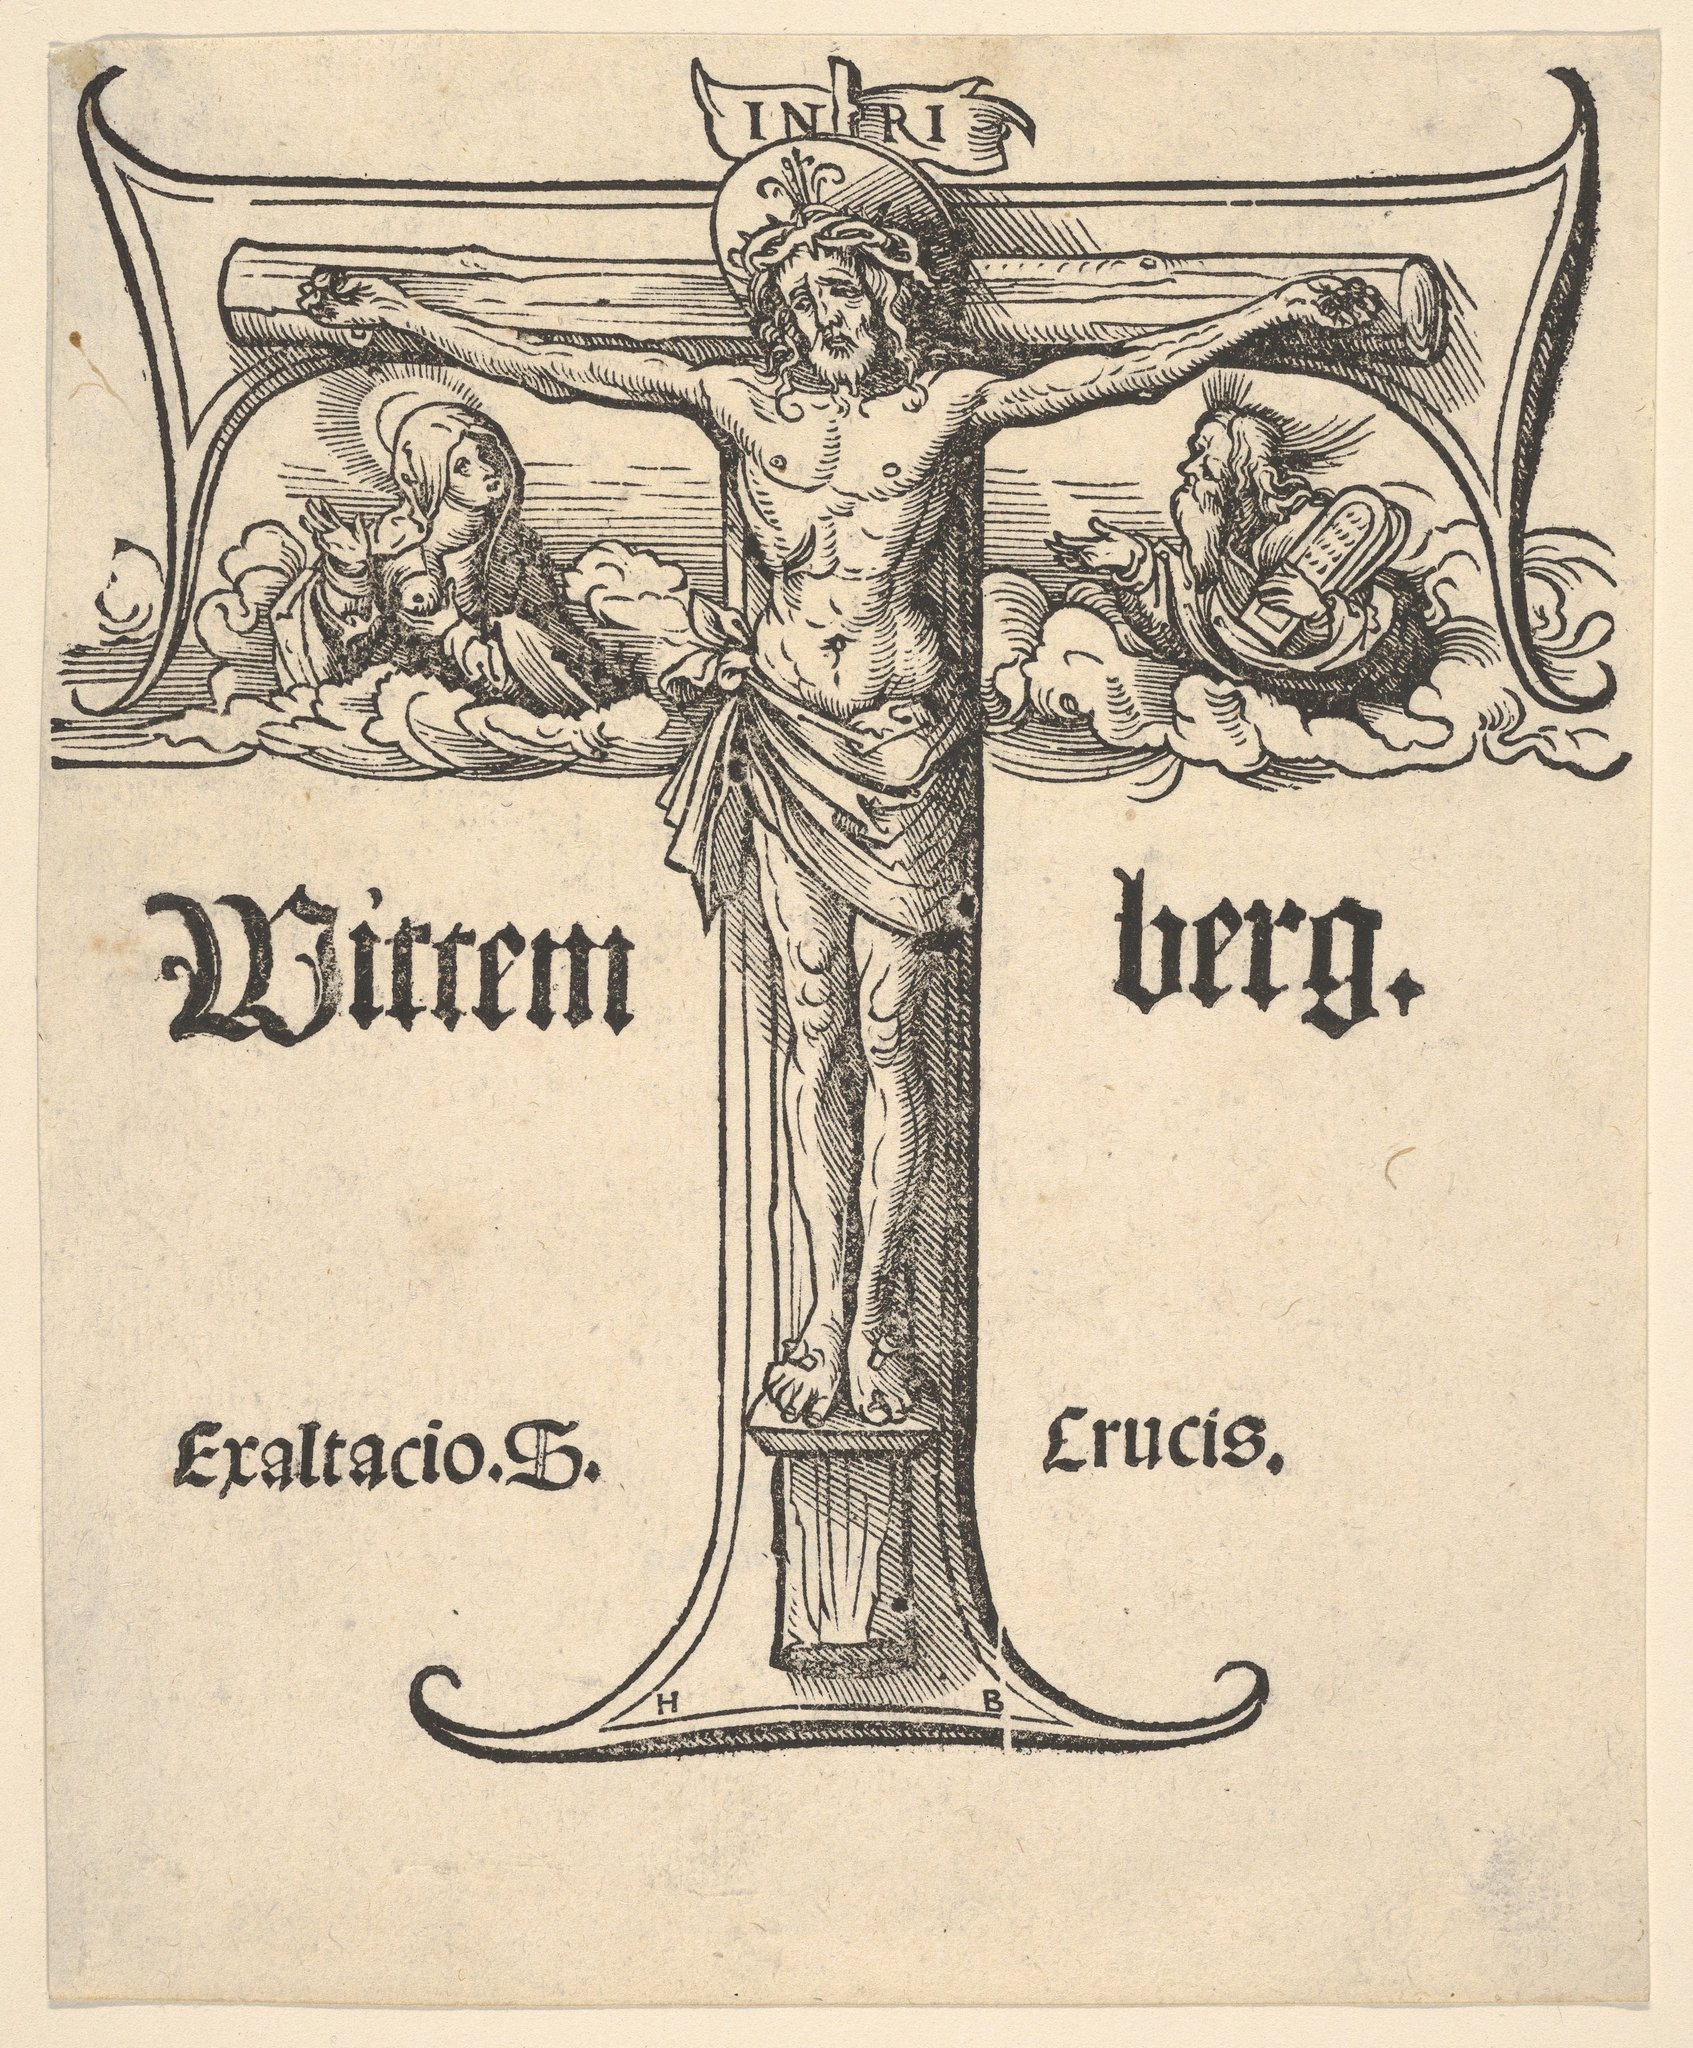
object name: print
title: Christ on the Cross Between the Virgin and Moses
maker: hans burgkmair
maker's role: artist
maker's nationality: german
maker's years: 1473-1531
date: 1498-1531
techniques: letterpress, woodcut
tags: christ,virgin mary,cross,moses,crucifixion